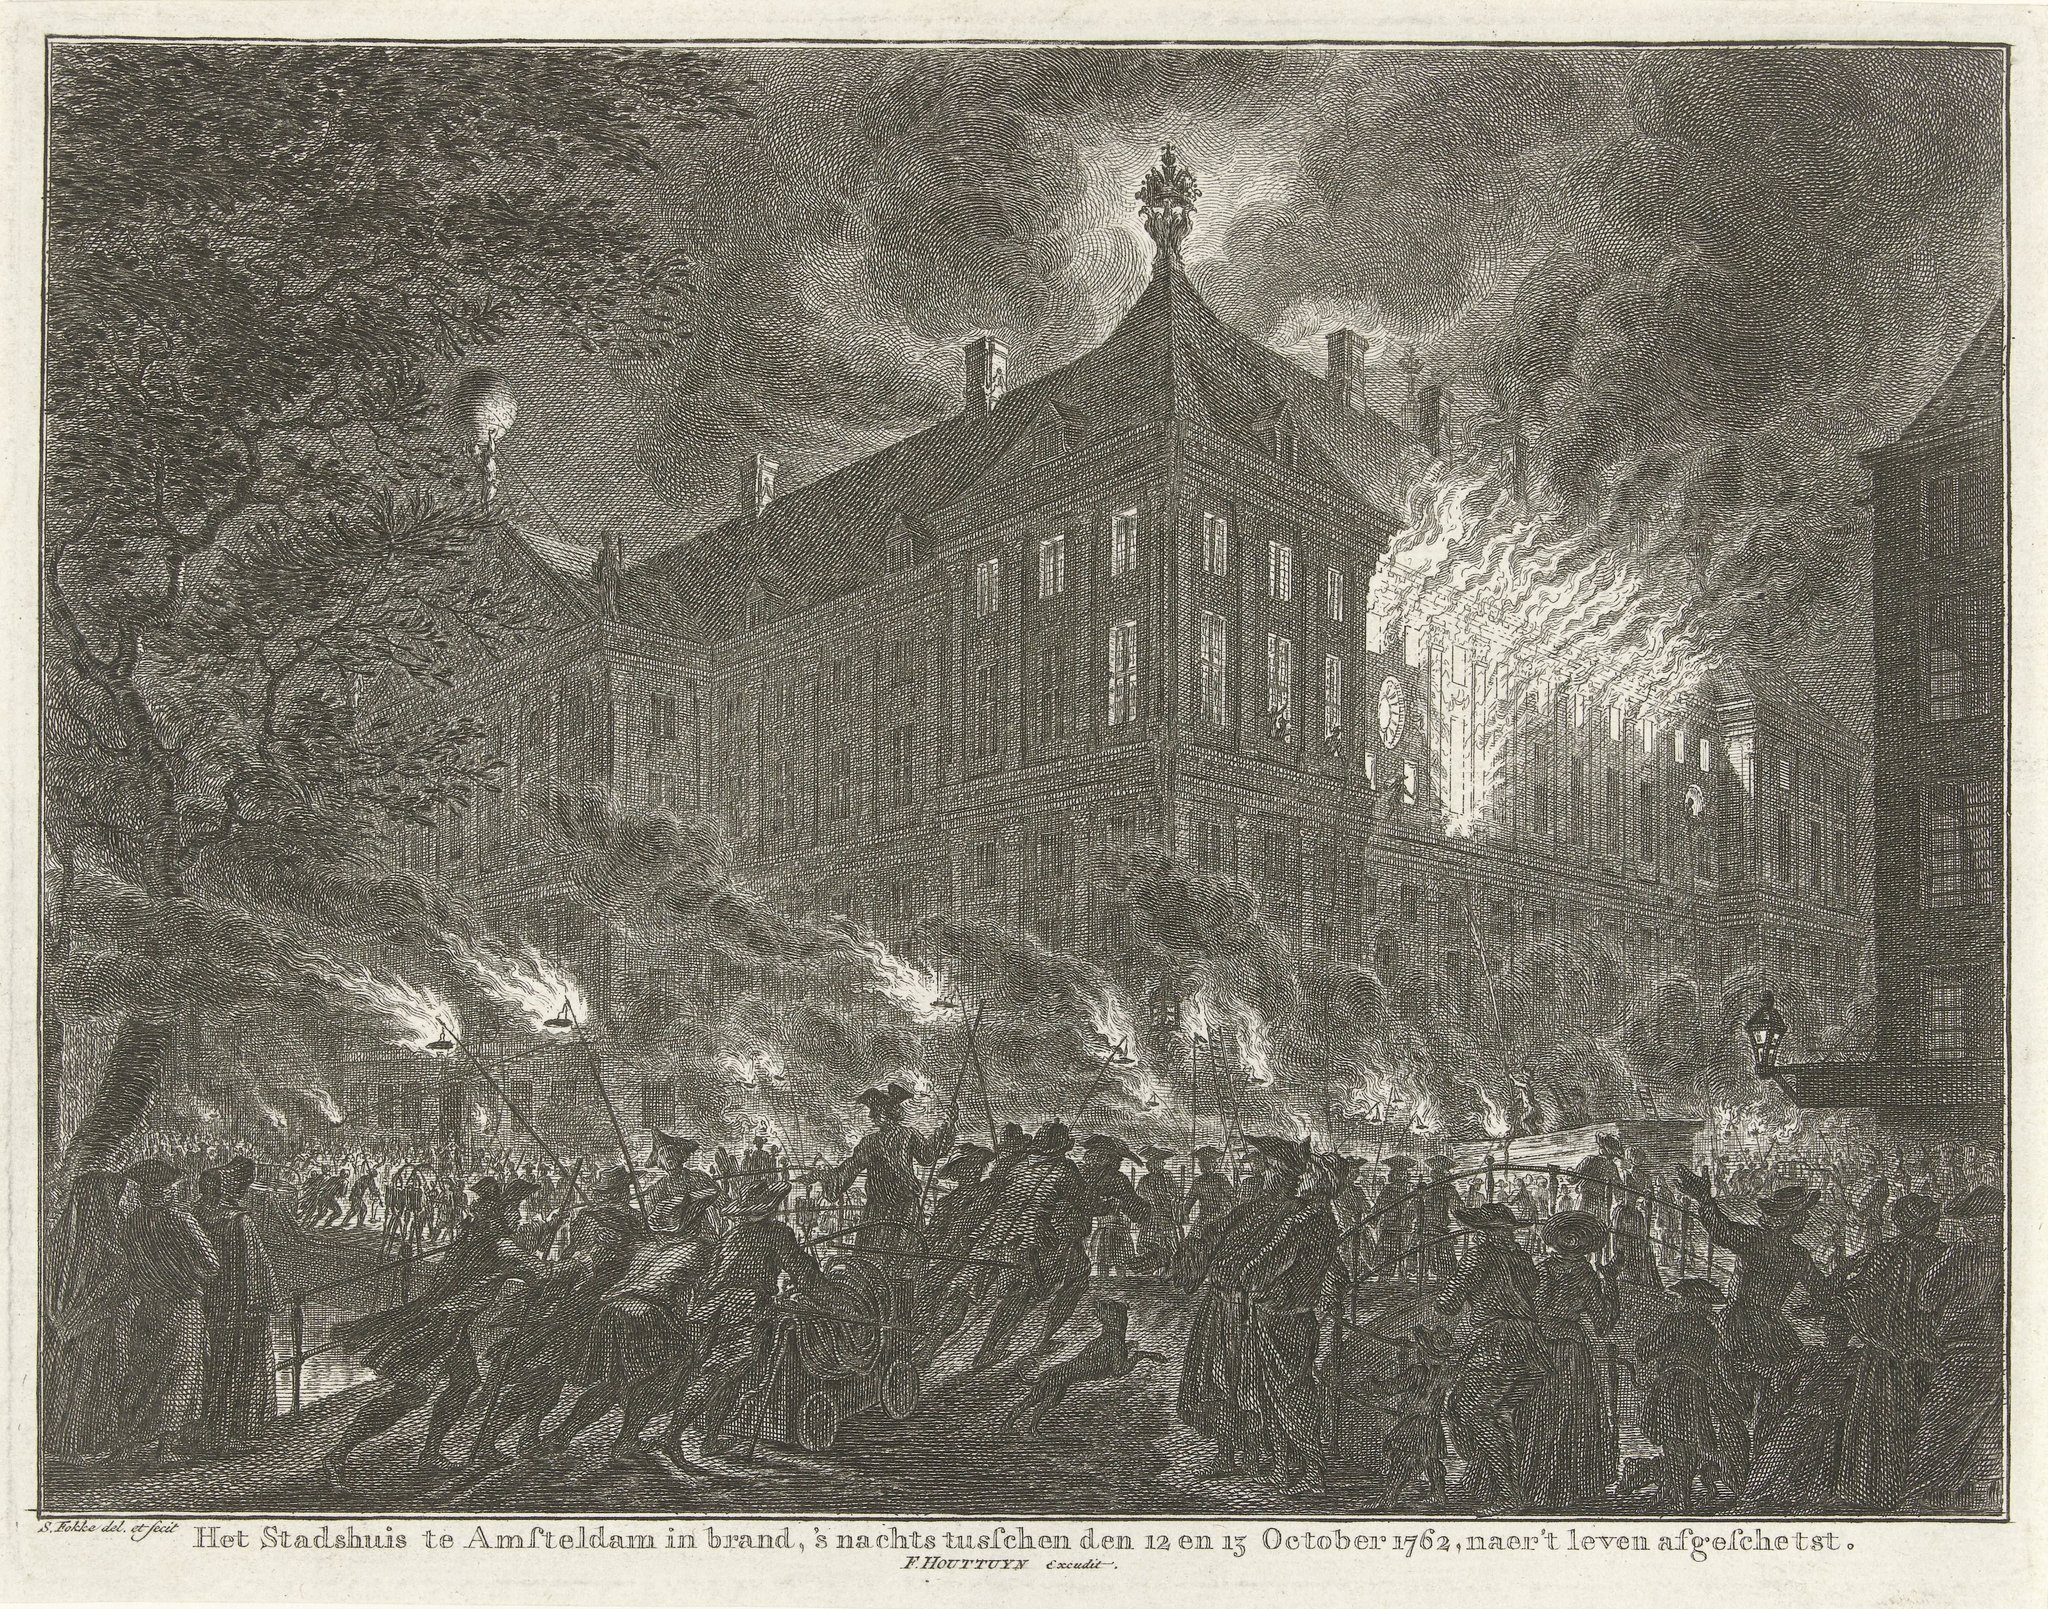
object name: print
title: Brand in het stadhuis van Amsterdam, 1762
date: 1762-1763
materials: paper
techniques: engraving, etching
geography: amsterdam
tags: on fire, ablaze, townhall, fire-fighting, fire-extinguishing equipment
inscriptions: collector's mark: Lugt 2228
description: Huidige staat van prent ook gebruikt in: Nederlandsche Jaerboeken, inhoudende een verhael van de merkwaerdigste geschiedenissen (…) Zestiende deel. 1762. Amsterdam: Frans Houttuyn, s.a. [1762-1763].